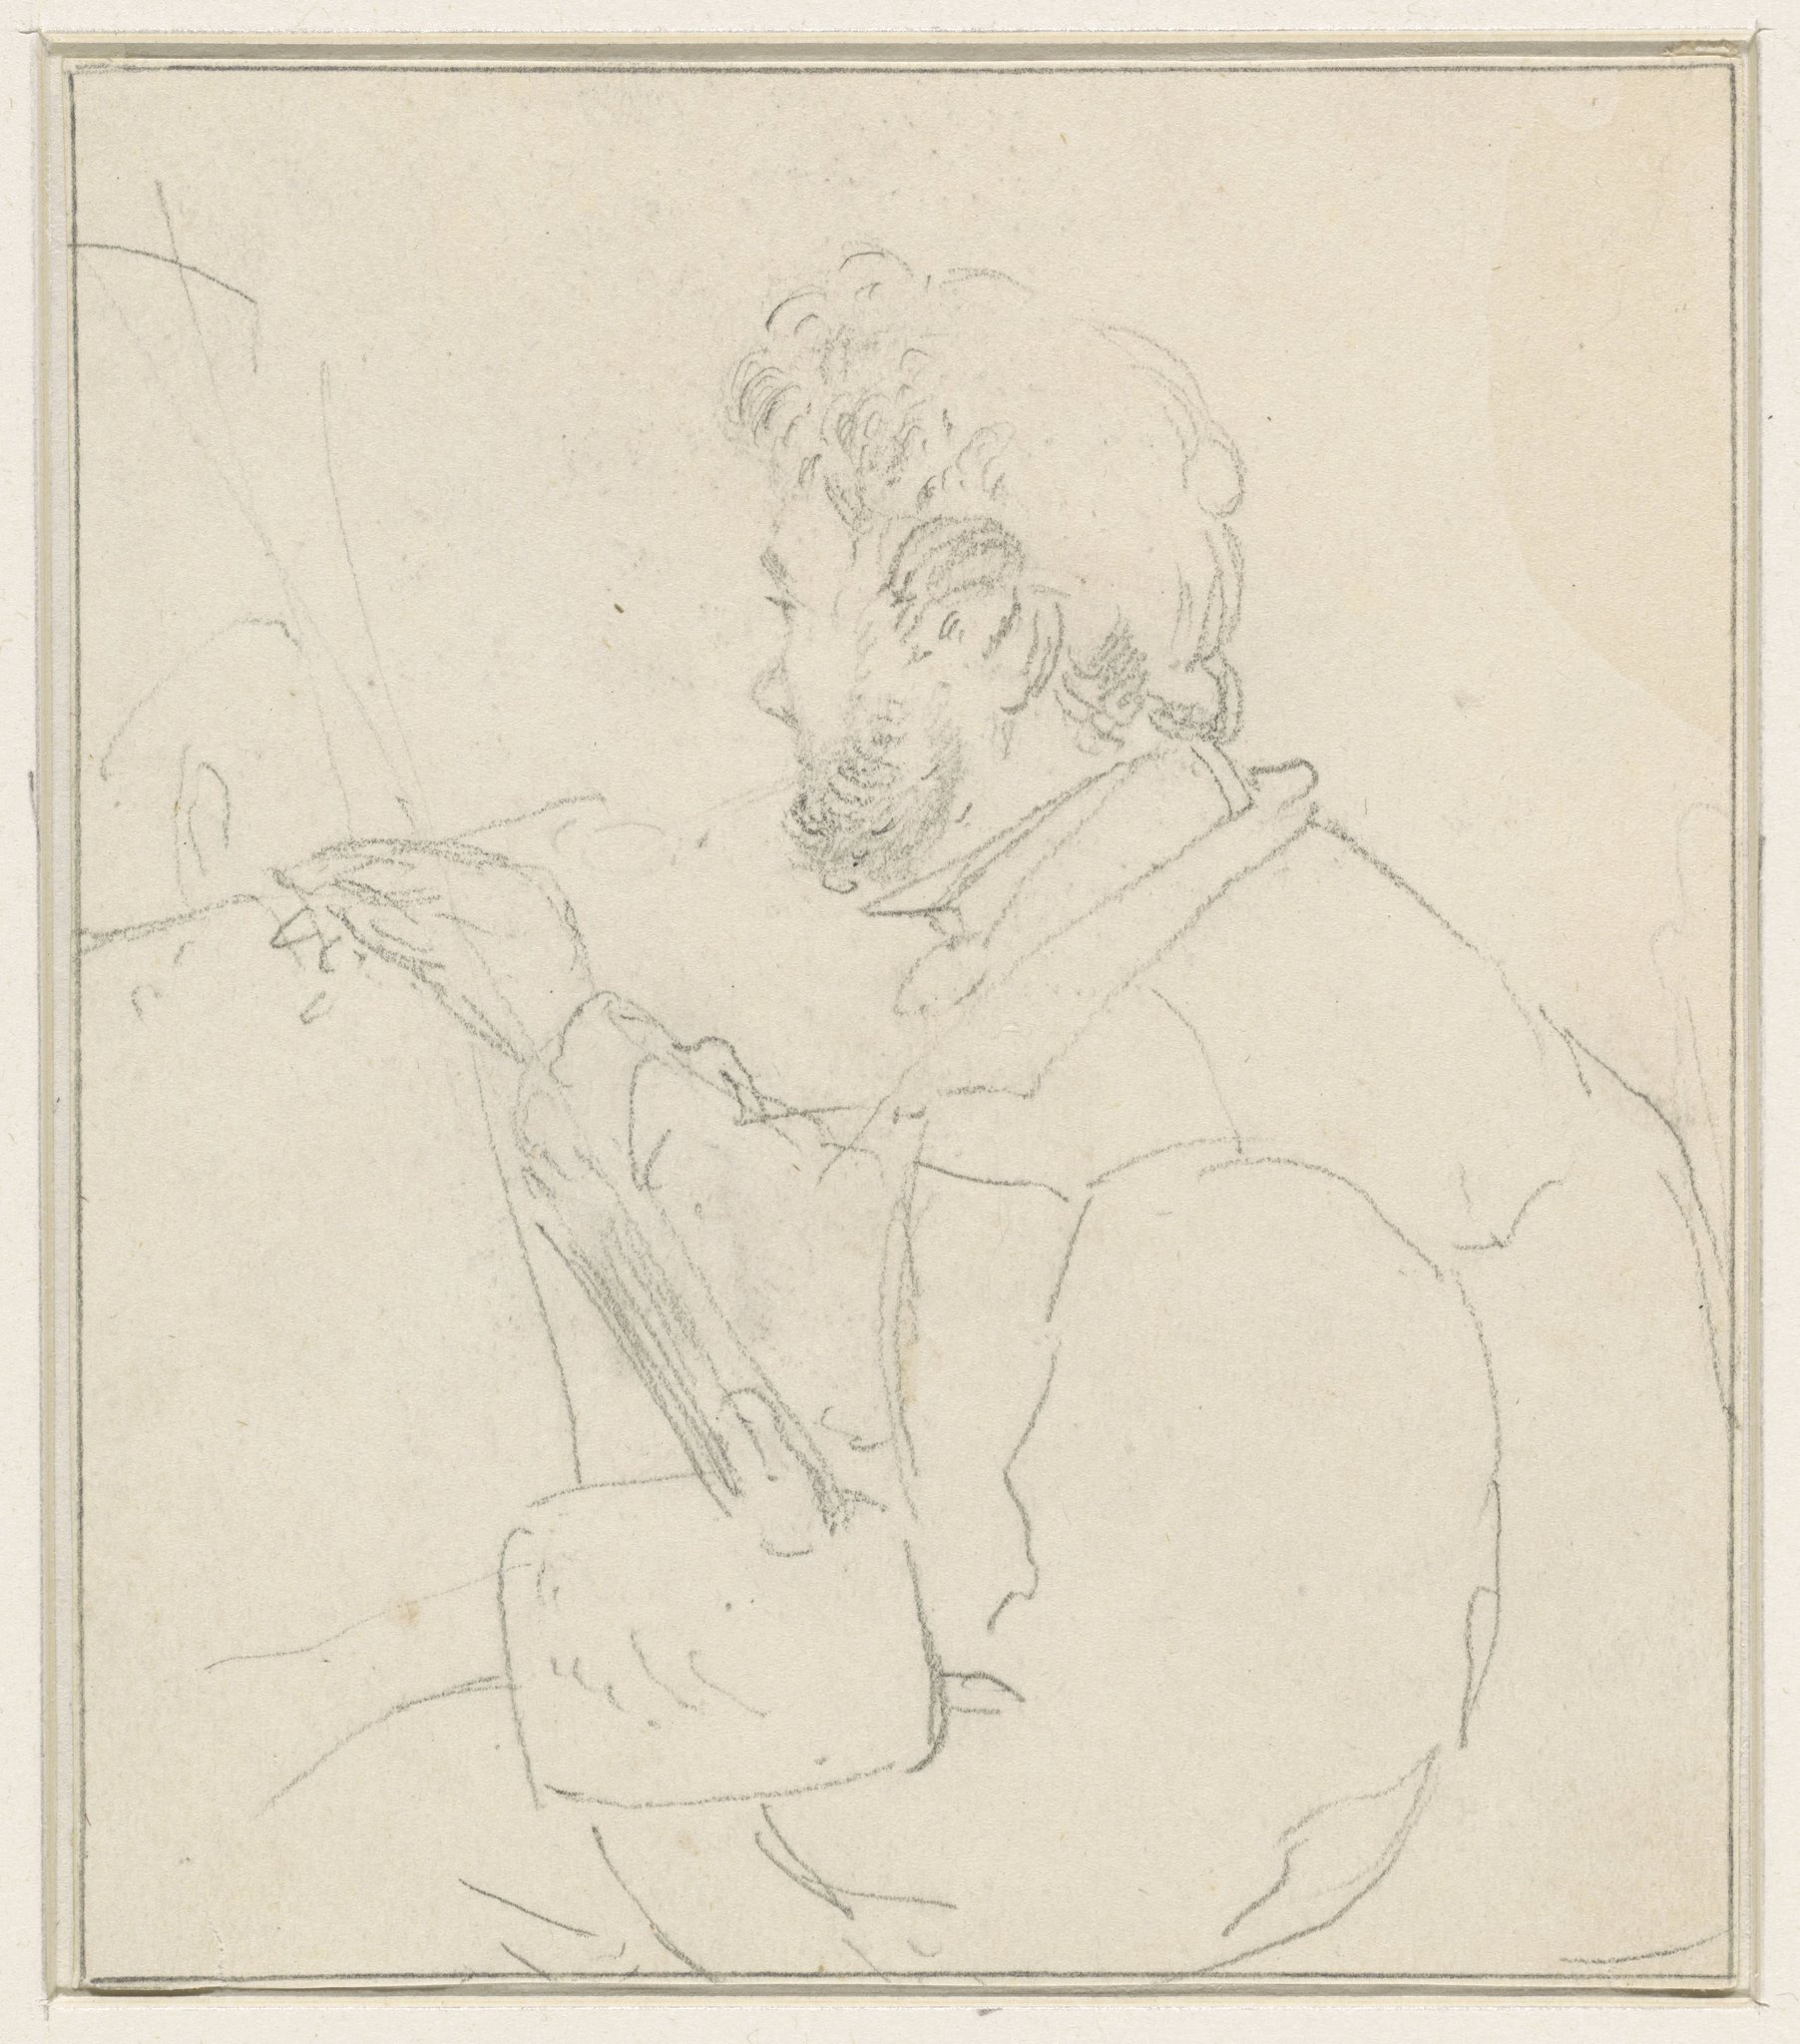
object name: drawing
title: Portret van Willem Pieter Hoevenaar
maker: gijsbertus craeyvanger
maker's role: draughtsman, print maker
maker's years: 1810-1895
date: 1828-1863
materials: paper, pencil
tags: willem pieter hoevenaar, historical persons, portrait, self-portrait of painter, portrait, self-portrait of artist, portrait, self-portrait of draughtsman